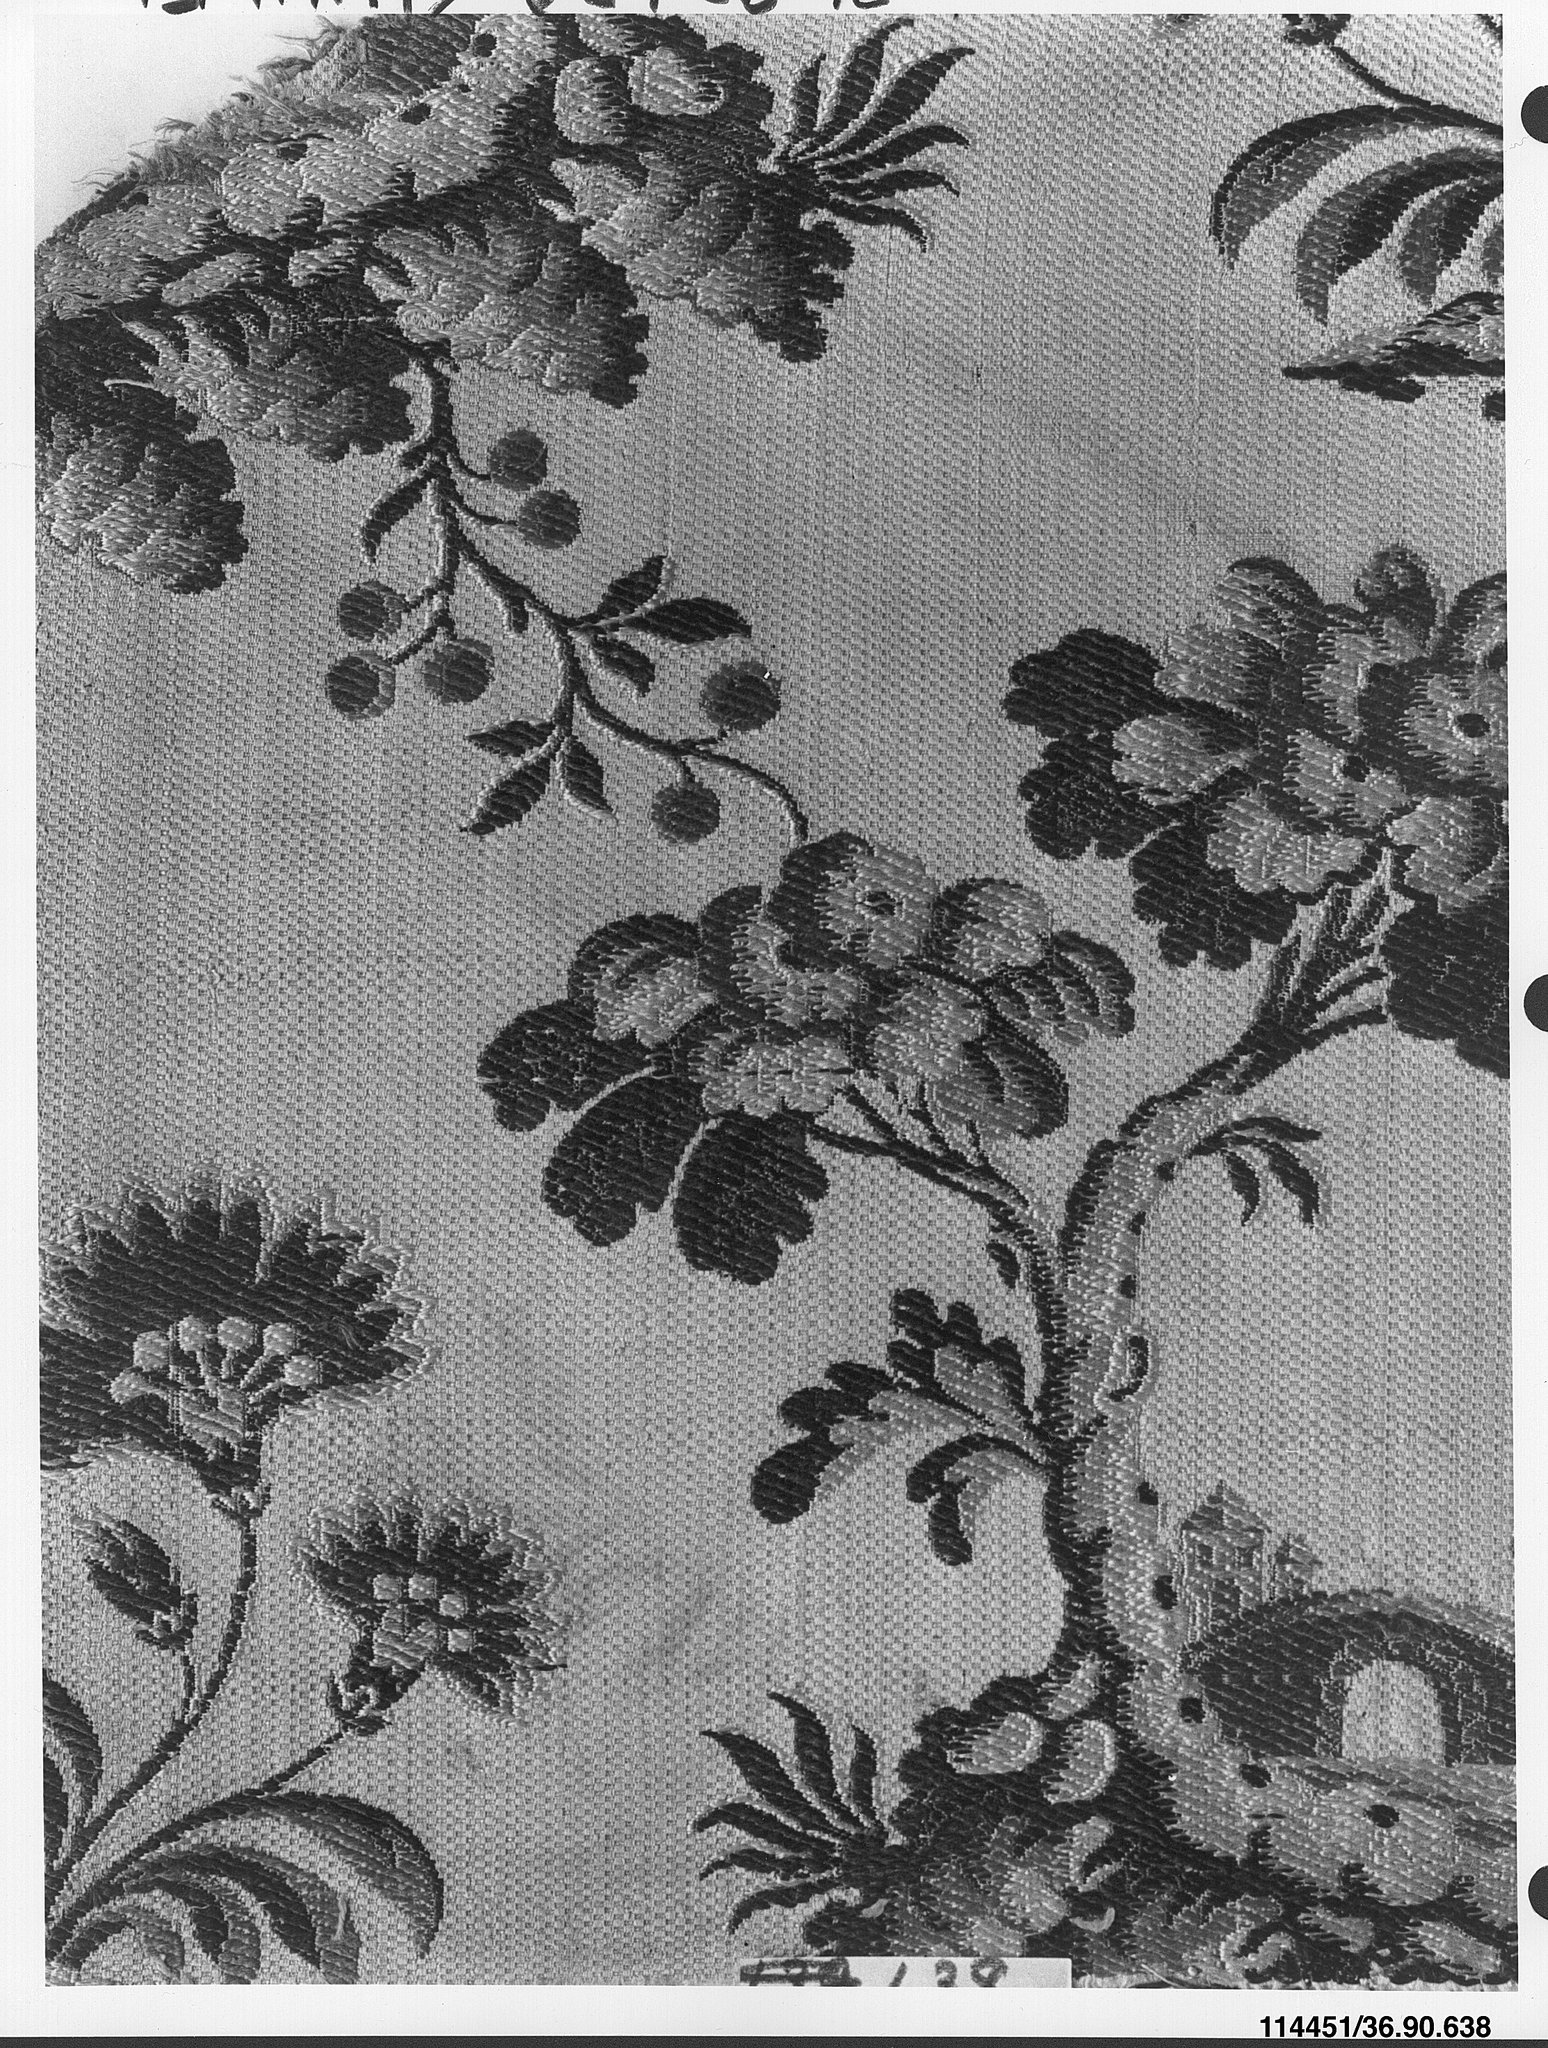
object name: piece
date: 1735-1740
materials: silk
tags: flowers,leaves